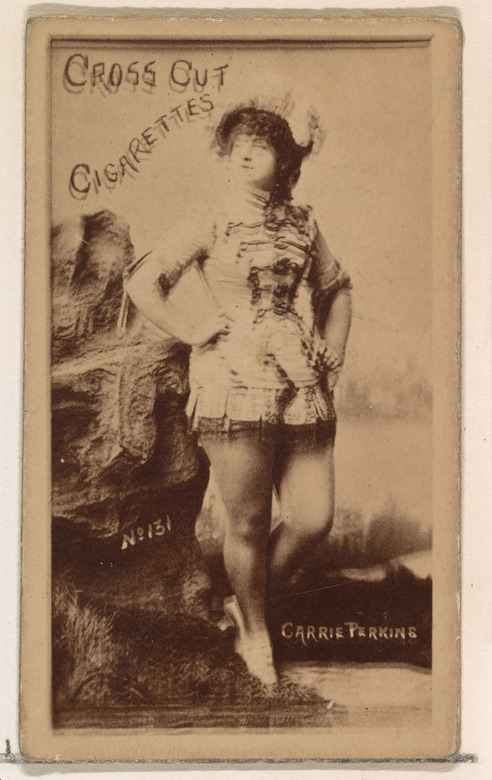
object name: print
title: Card Number 131, Carrie Perkins, from the Actors and Actresses series (N145-1) issued by Duke Sons & Co. to promote Cross Cut Cigarettes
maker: w. duke, sons & co.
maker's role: publisher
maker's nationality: american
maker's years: 1870-1920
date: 1880-1889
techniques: albumen silver print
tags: portraits,women,actresses